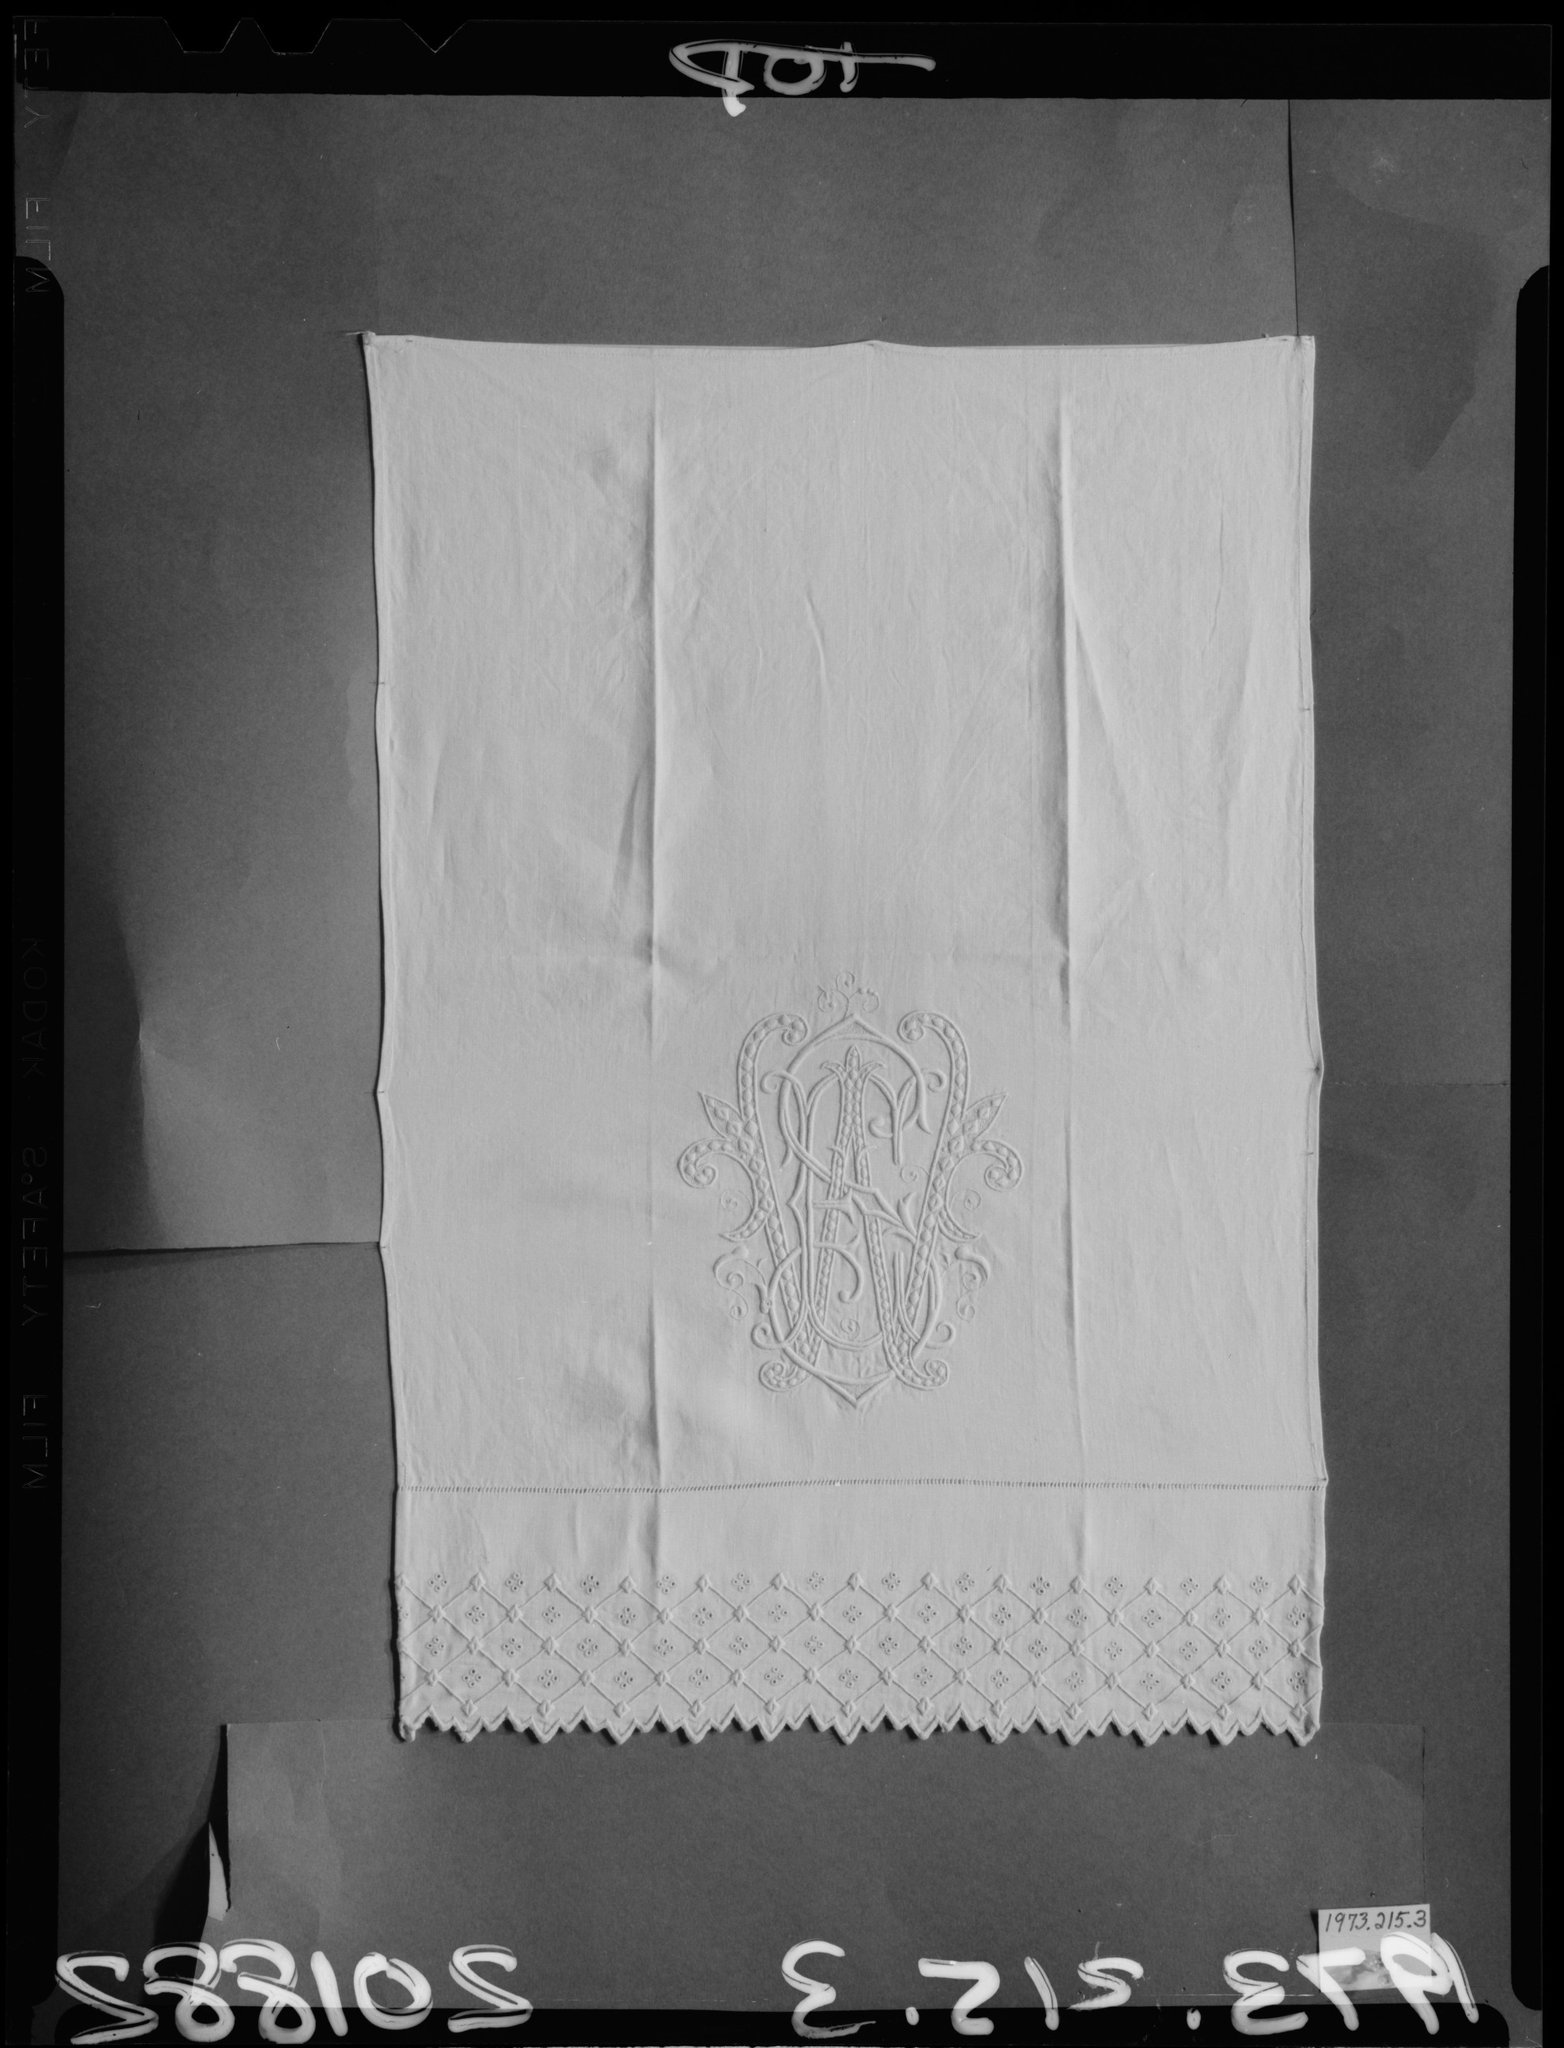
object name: sham panel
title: Panel from a sham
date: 1890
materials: linen